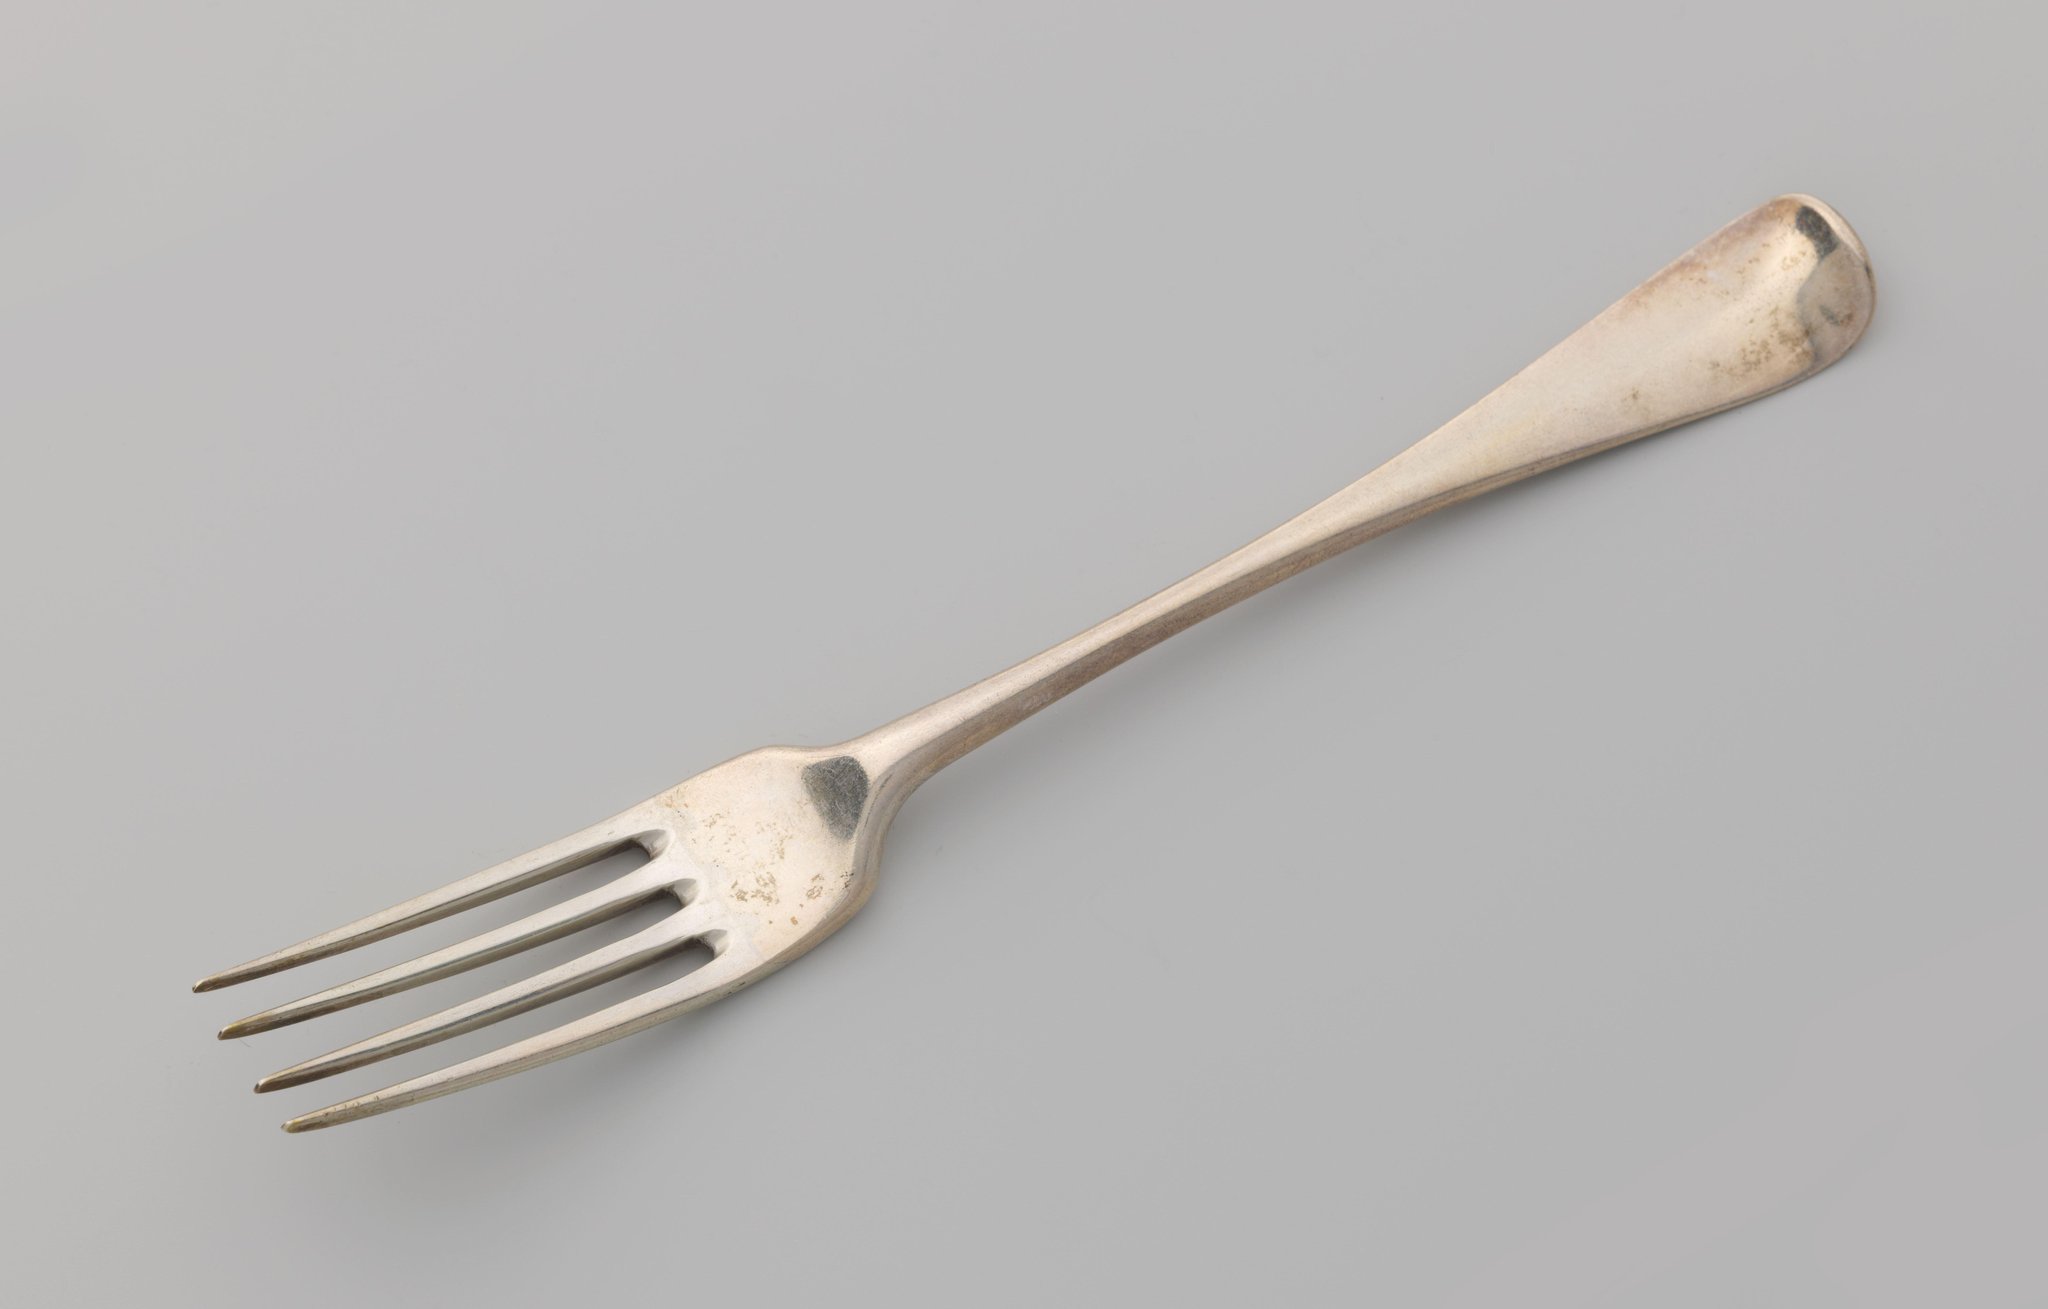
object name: fork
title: Vork van zilver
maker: dirk van gameren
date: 1764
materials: silver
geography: utrecht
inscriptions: mark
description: Vork van zilver, met 4 tanden. De vork gaat geleidelijk over in de platte steel die zich verbreedt naar het afgeronde uiteinde.